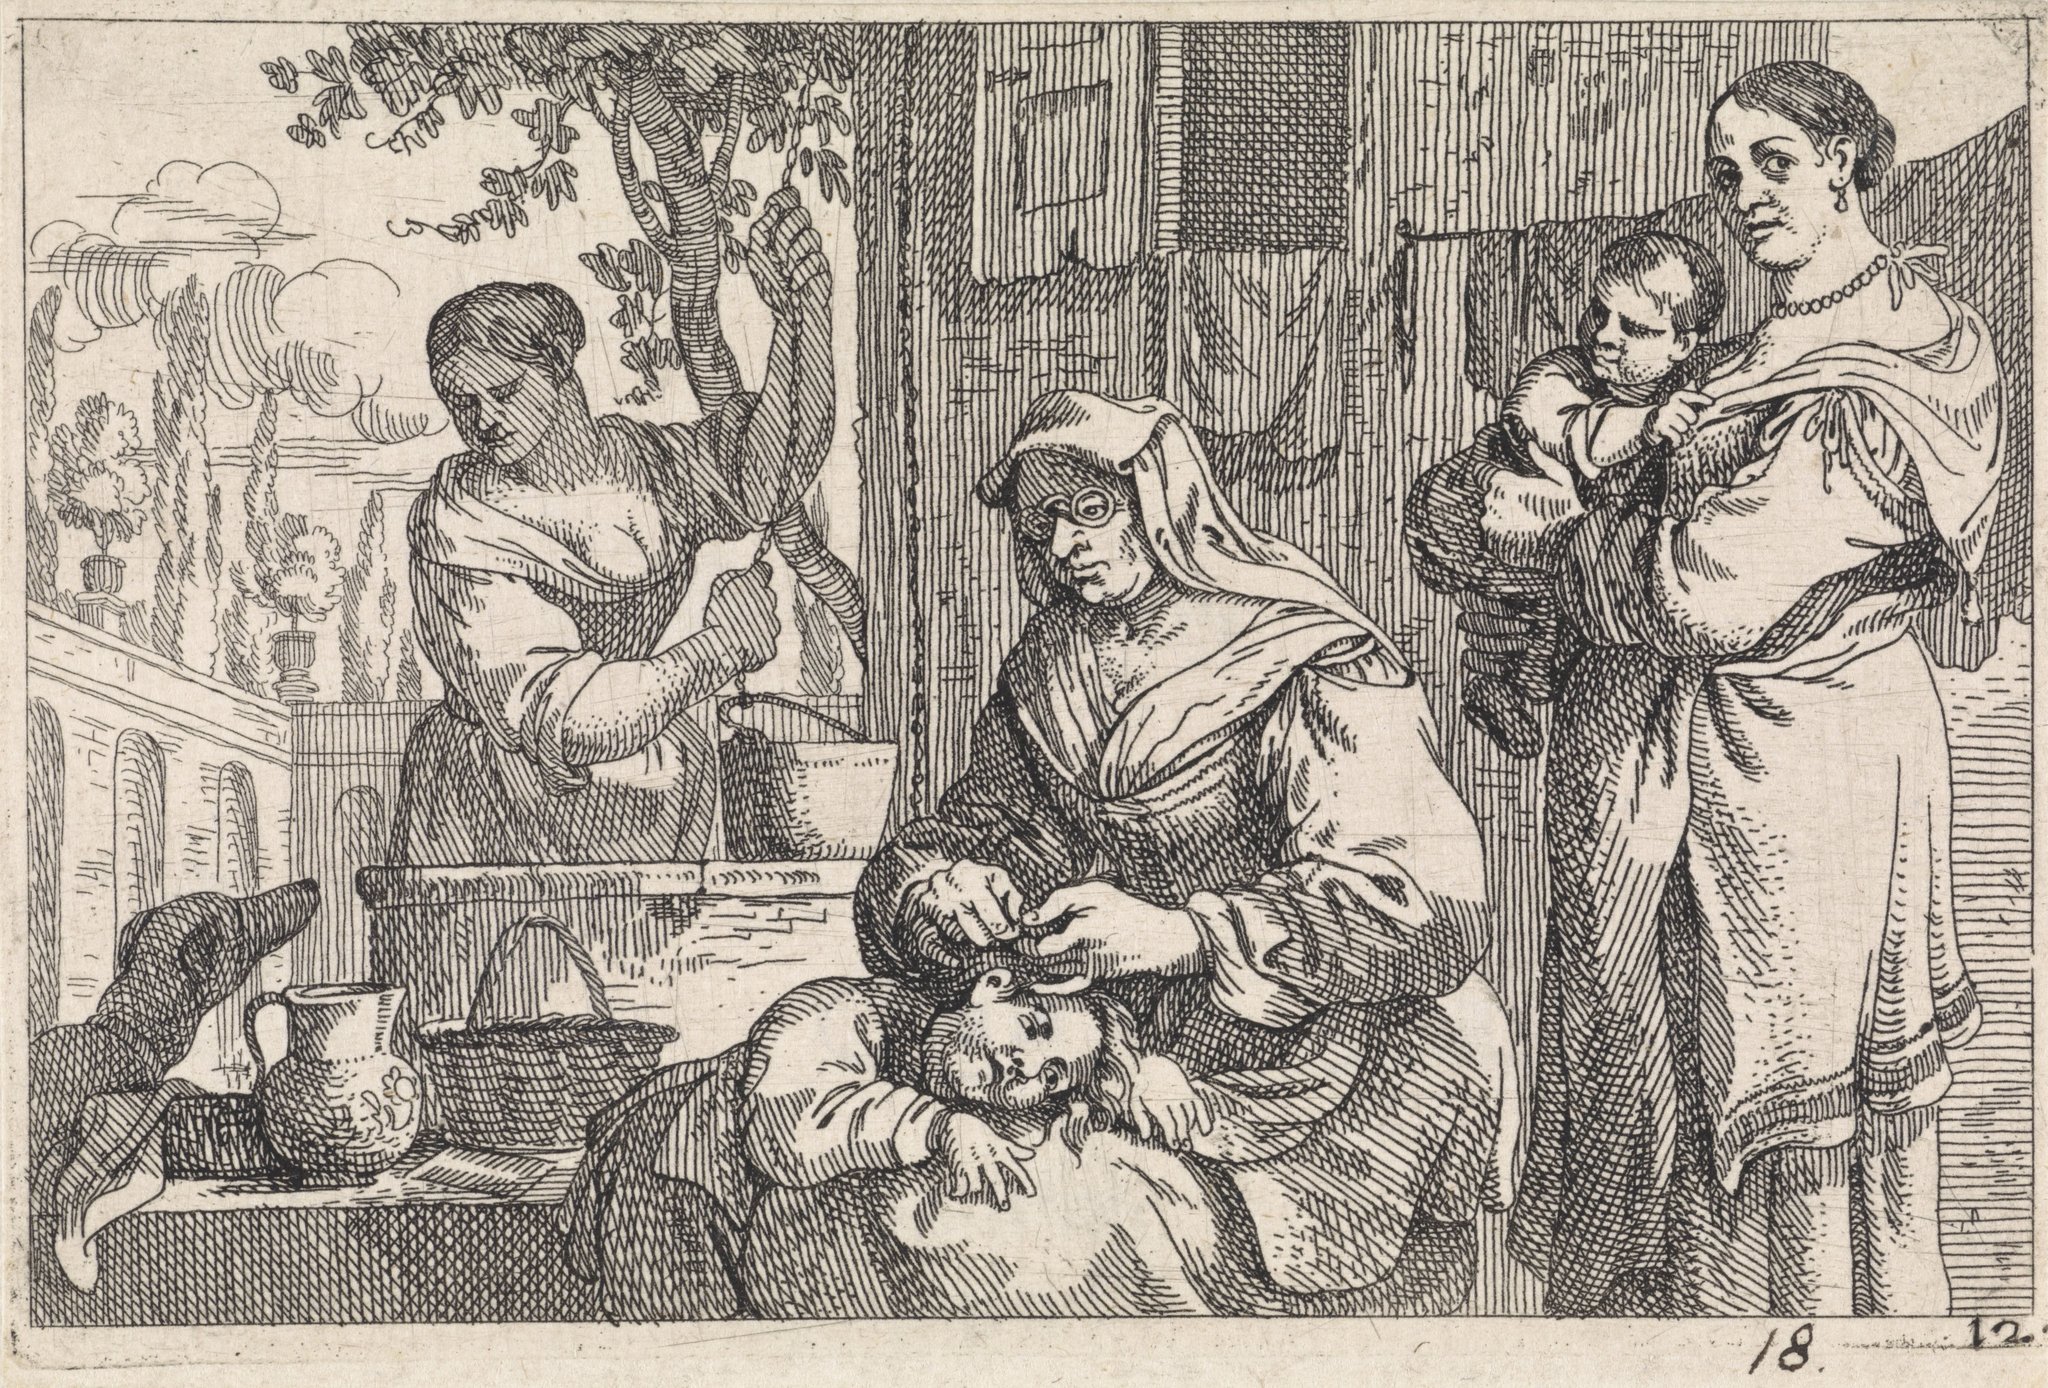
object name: print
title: Diverse genretaferelen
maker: jan baptist de wael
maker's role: print maker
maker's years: 1632-1669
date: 1642-1669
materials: paper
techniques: etching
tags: well, 'motherly care', delousing - aa - female human figure, mother and baby or young child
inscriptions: collector's mark: Lugt 2228, number: ‘18’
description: Een oude vrouw zit voor een huis en ontluist een kind. Het kind houdt het hoofd in de schoot van de vrouw. Rechts een vrouw met een kind op de arm die de beschouwer aankijkt. Op de achtergrond een vrouw die met een emmer water uit een put haalt. Bij het huis hangt was te drogen aan een waslijn.